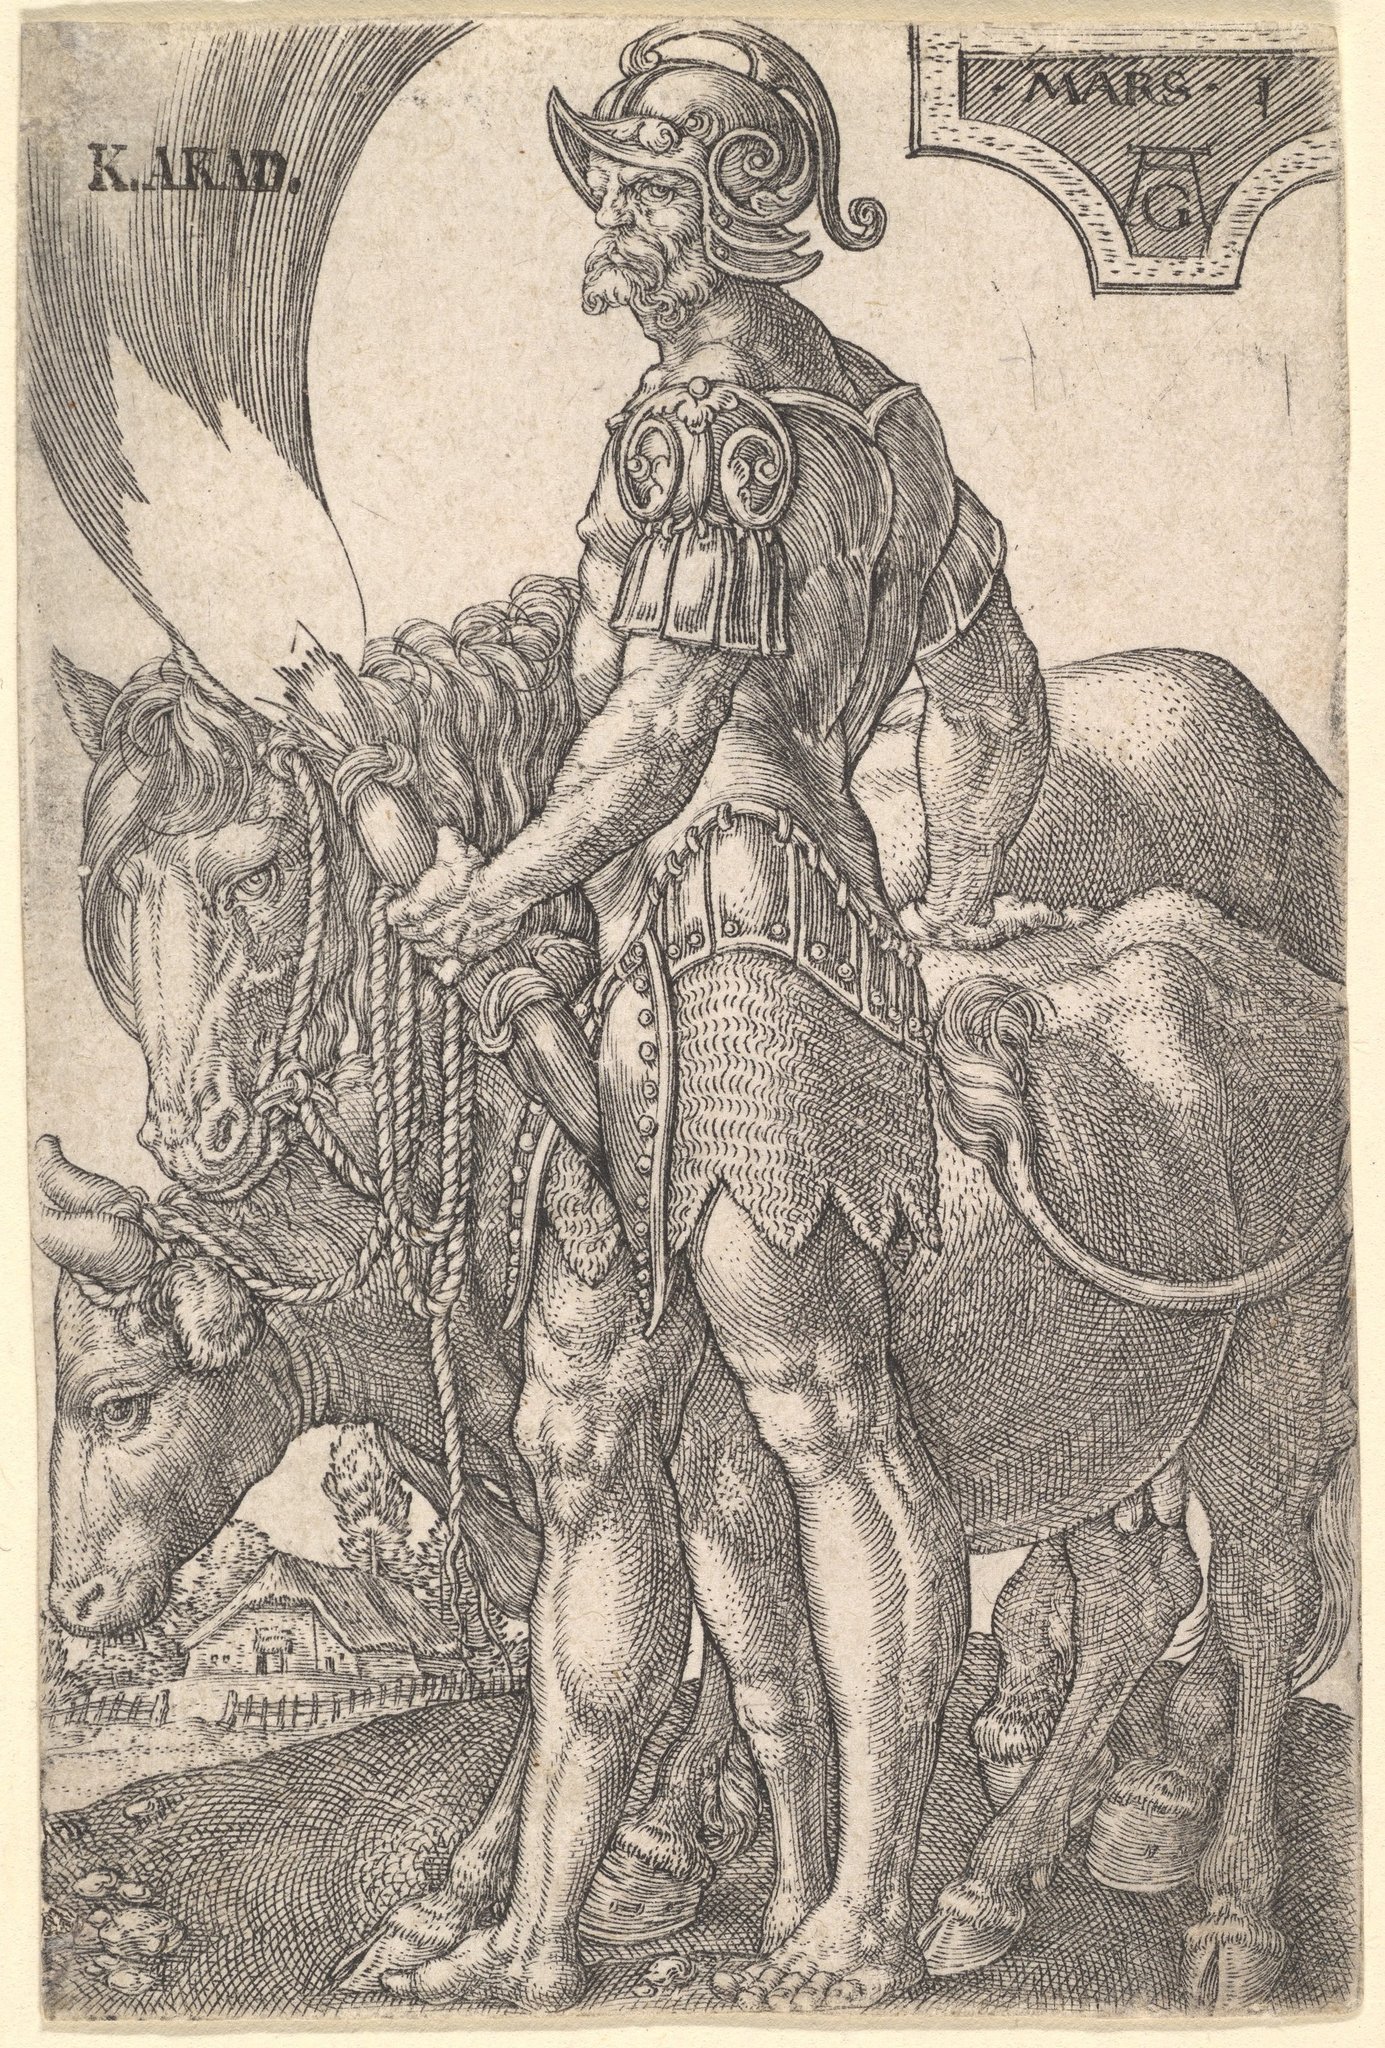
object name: print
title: Mars, from "The Seven Planets"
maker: heinrich aldegrever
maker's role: artist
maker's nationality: german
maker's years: 1502-1561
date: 1533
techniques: engraving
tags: mars,cows,horses